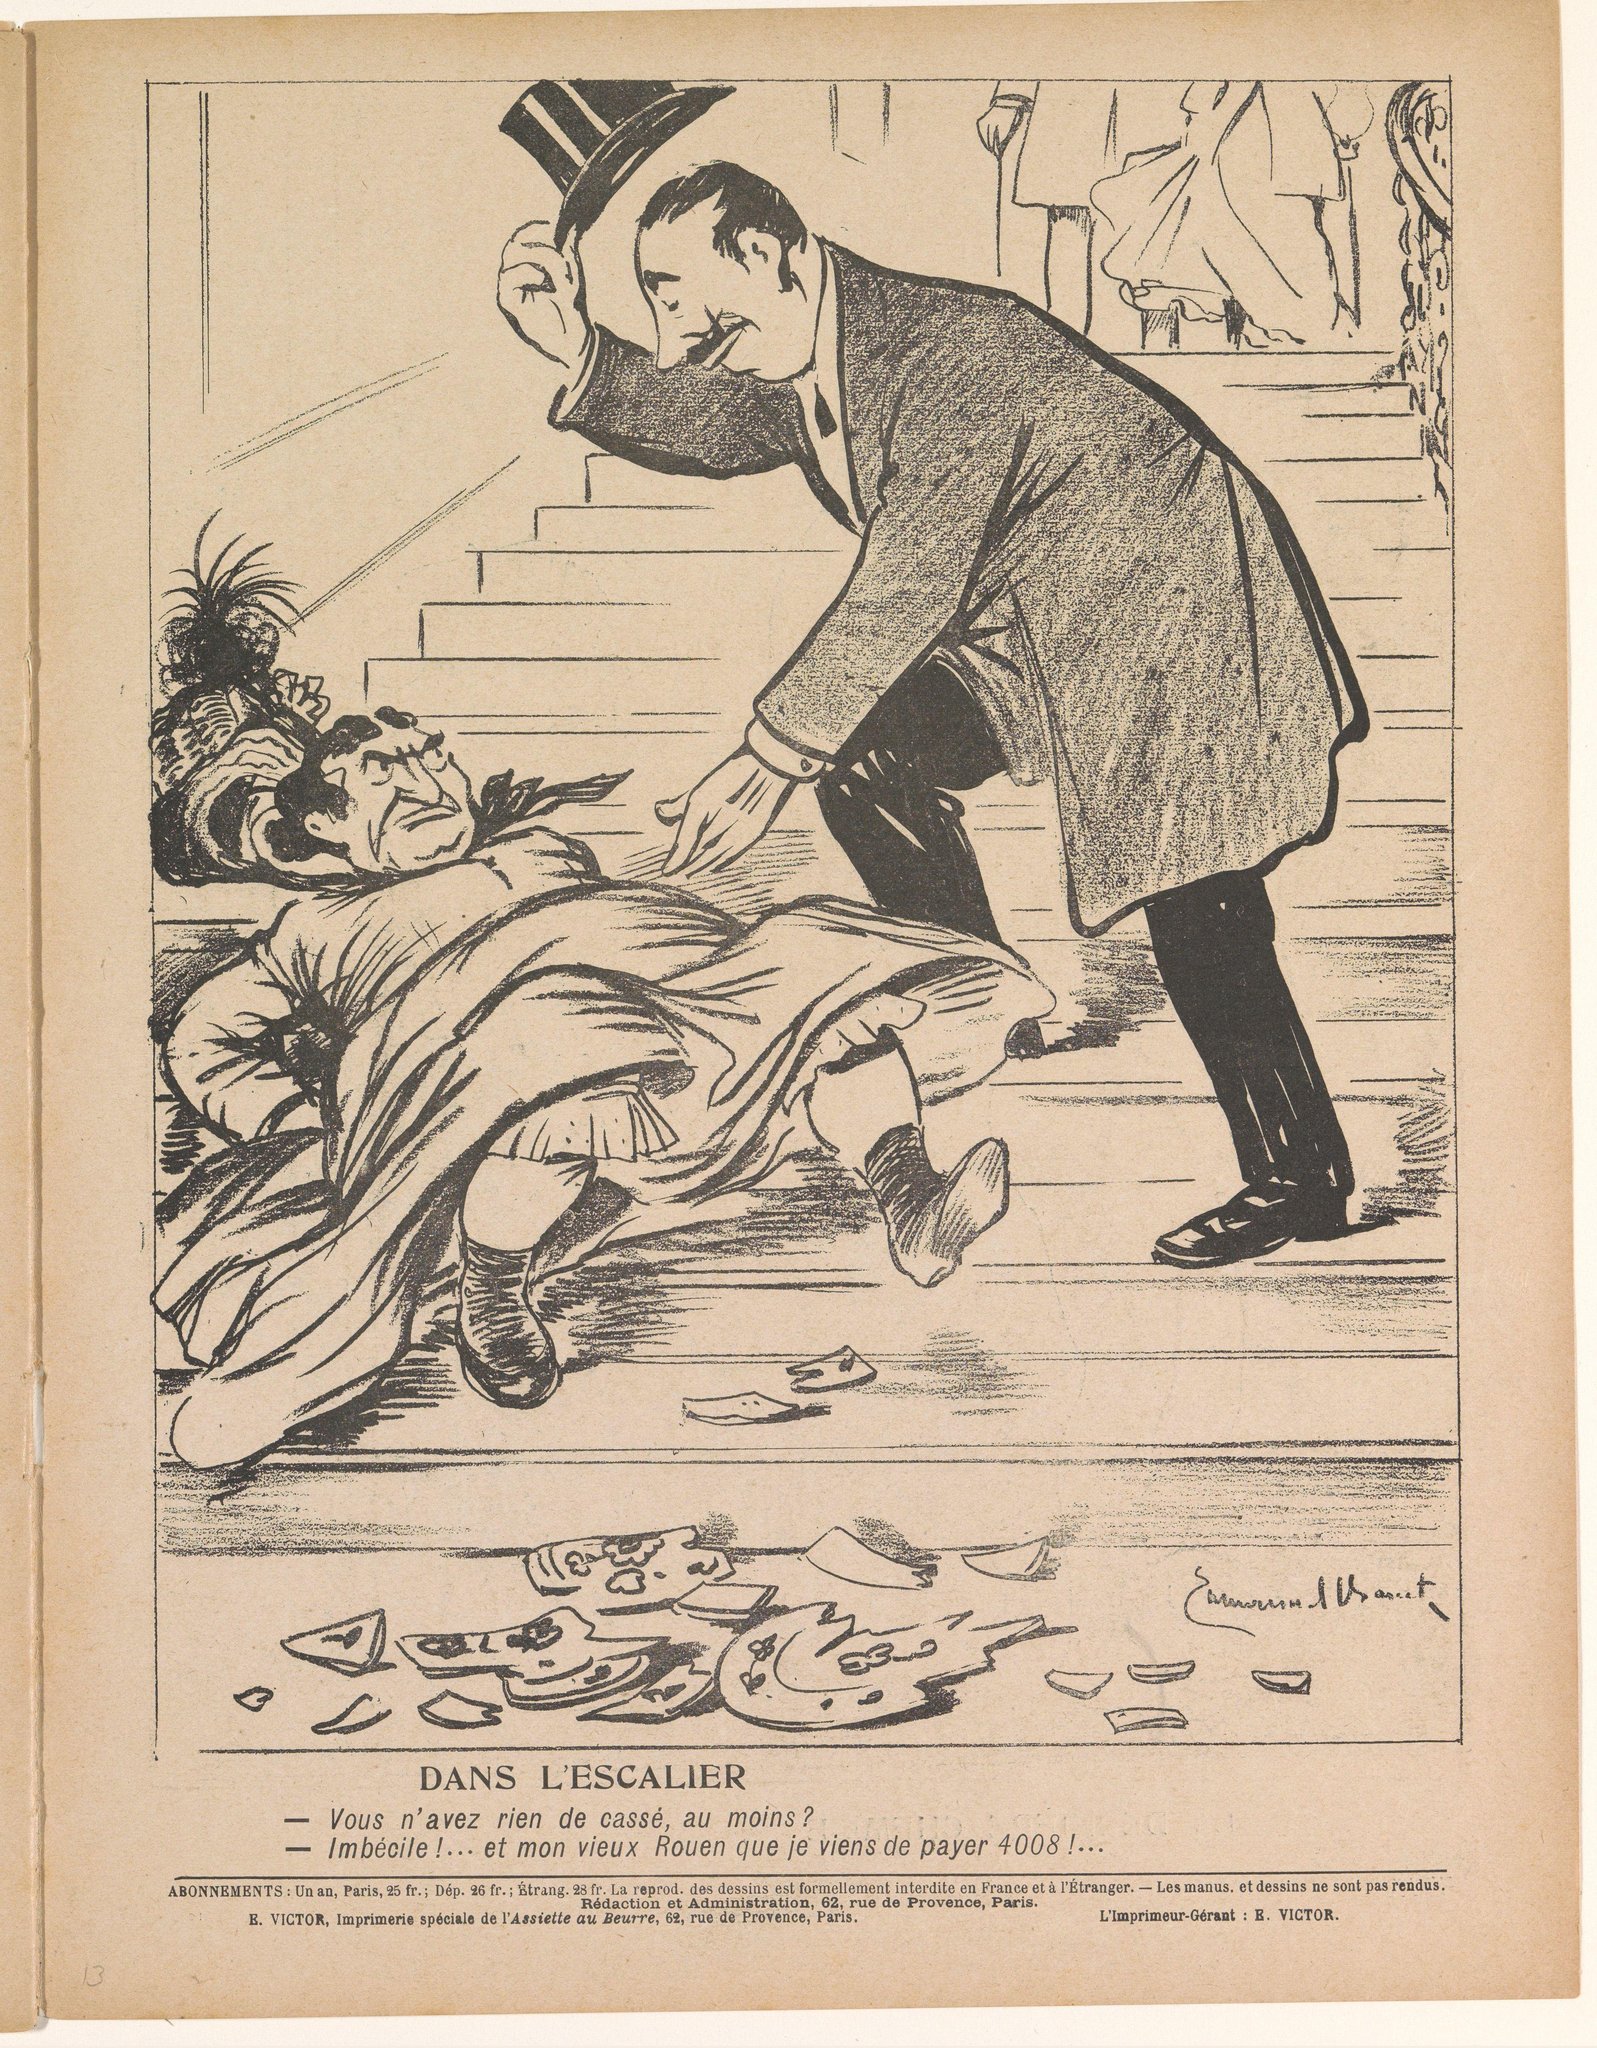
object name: magazine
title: Dans l'escalier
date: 1905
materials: paper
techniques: lithograph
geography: paris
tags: container of ceramics: jar, jug, pot, vase (+ broken, damaged), caricatures (human types), slipping - aa - female human figure, auction sale, public sale, art sale, auction, political caricatures and satires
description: Op de trap van een veilinghuis is een vrouw uitgegleden. Op de voorgrond liggen fragmenten van een stuk porselein uit Rouen. Een man met een hoed helpt de vrouw omhoog en informeert of ze niets gebroken heeft. De prent maakt onderdeel uit van een tijdschrift.